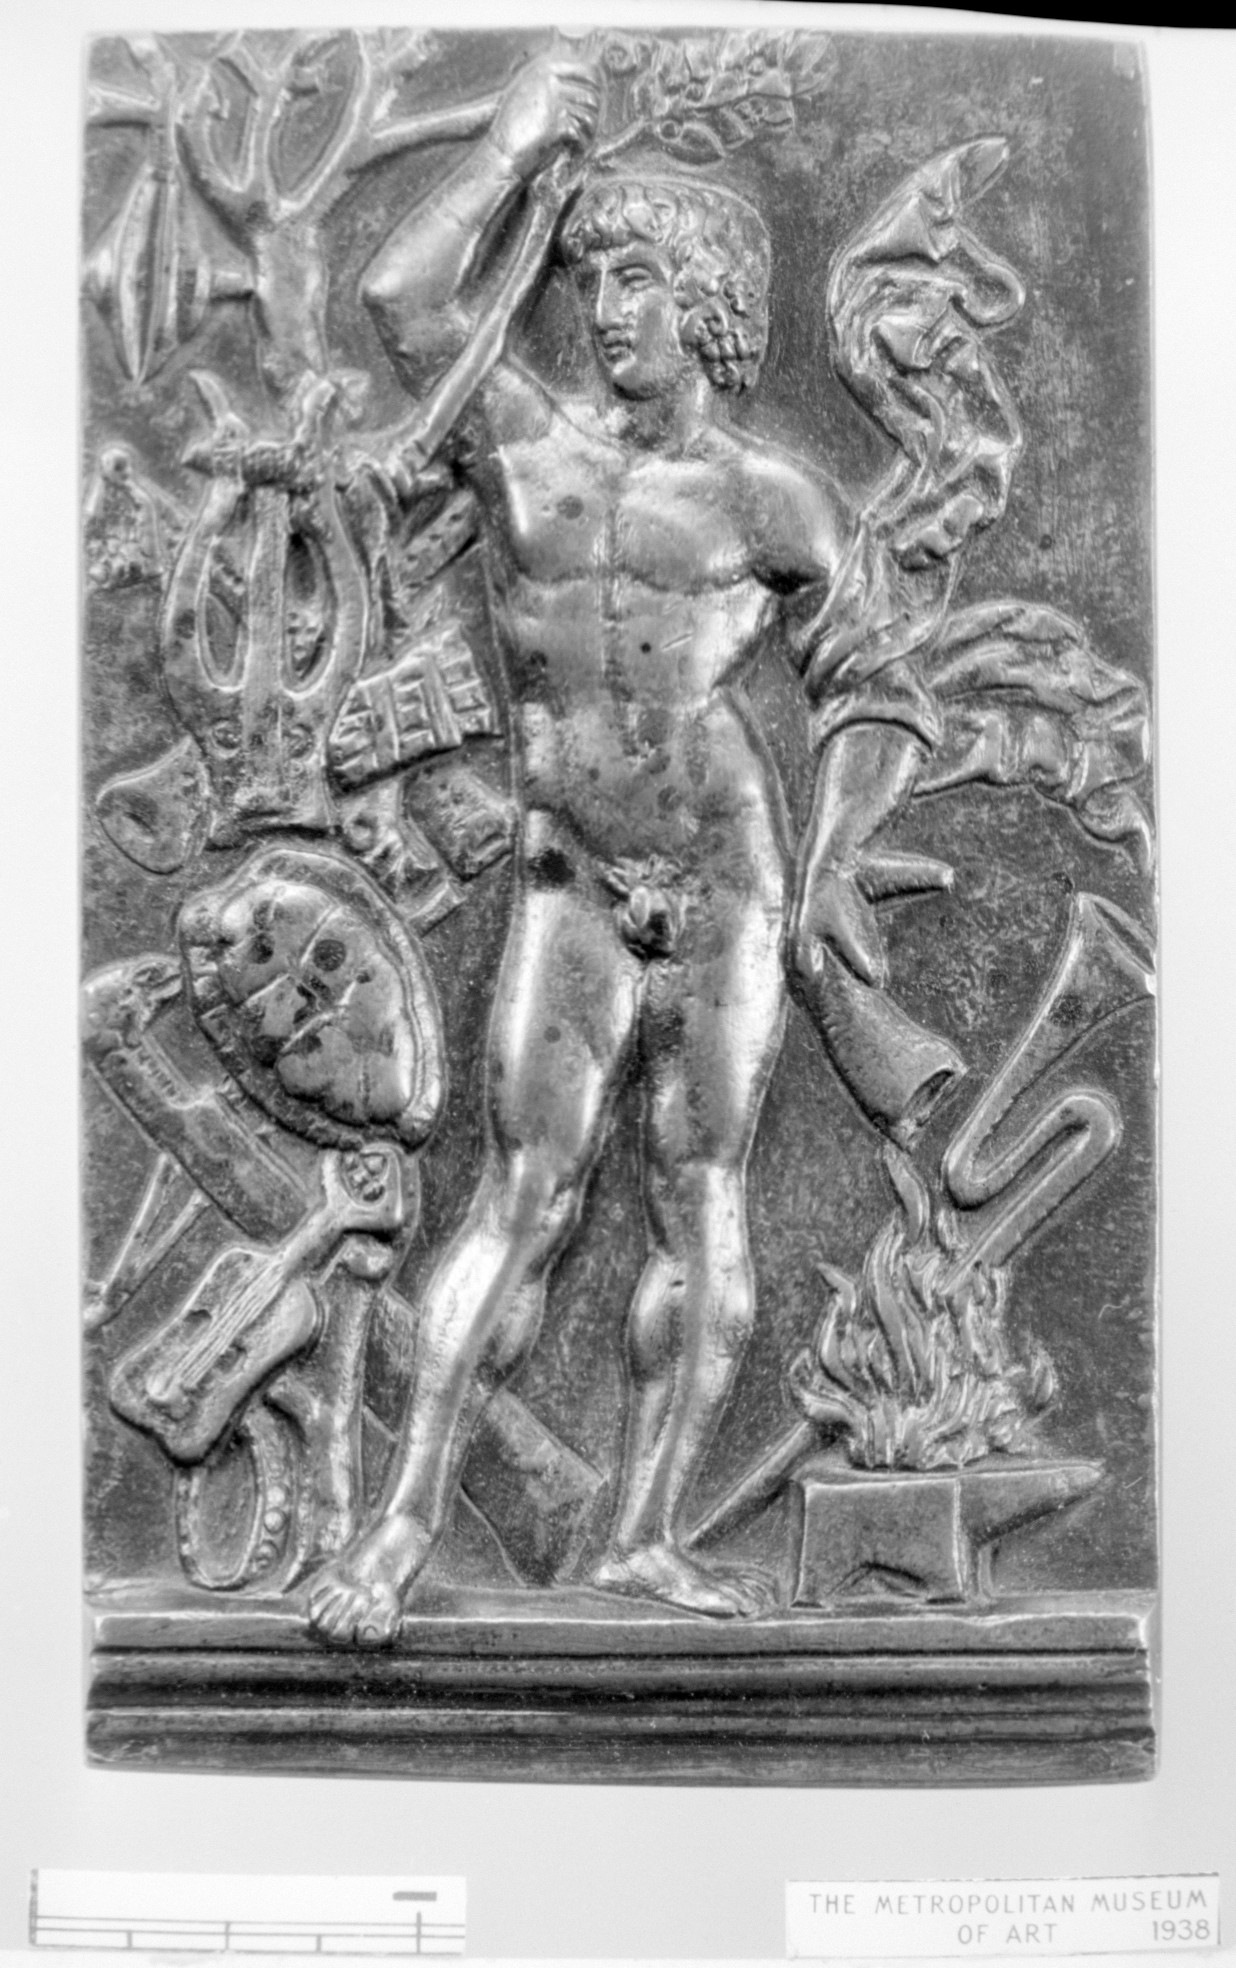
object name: plaquette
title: The Genius of Music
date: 1467-1533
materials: bronze, patina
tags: musical instruments,male nudes